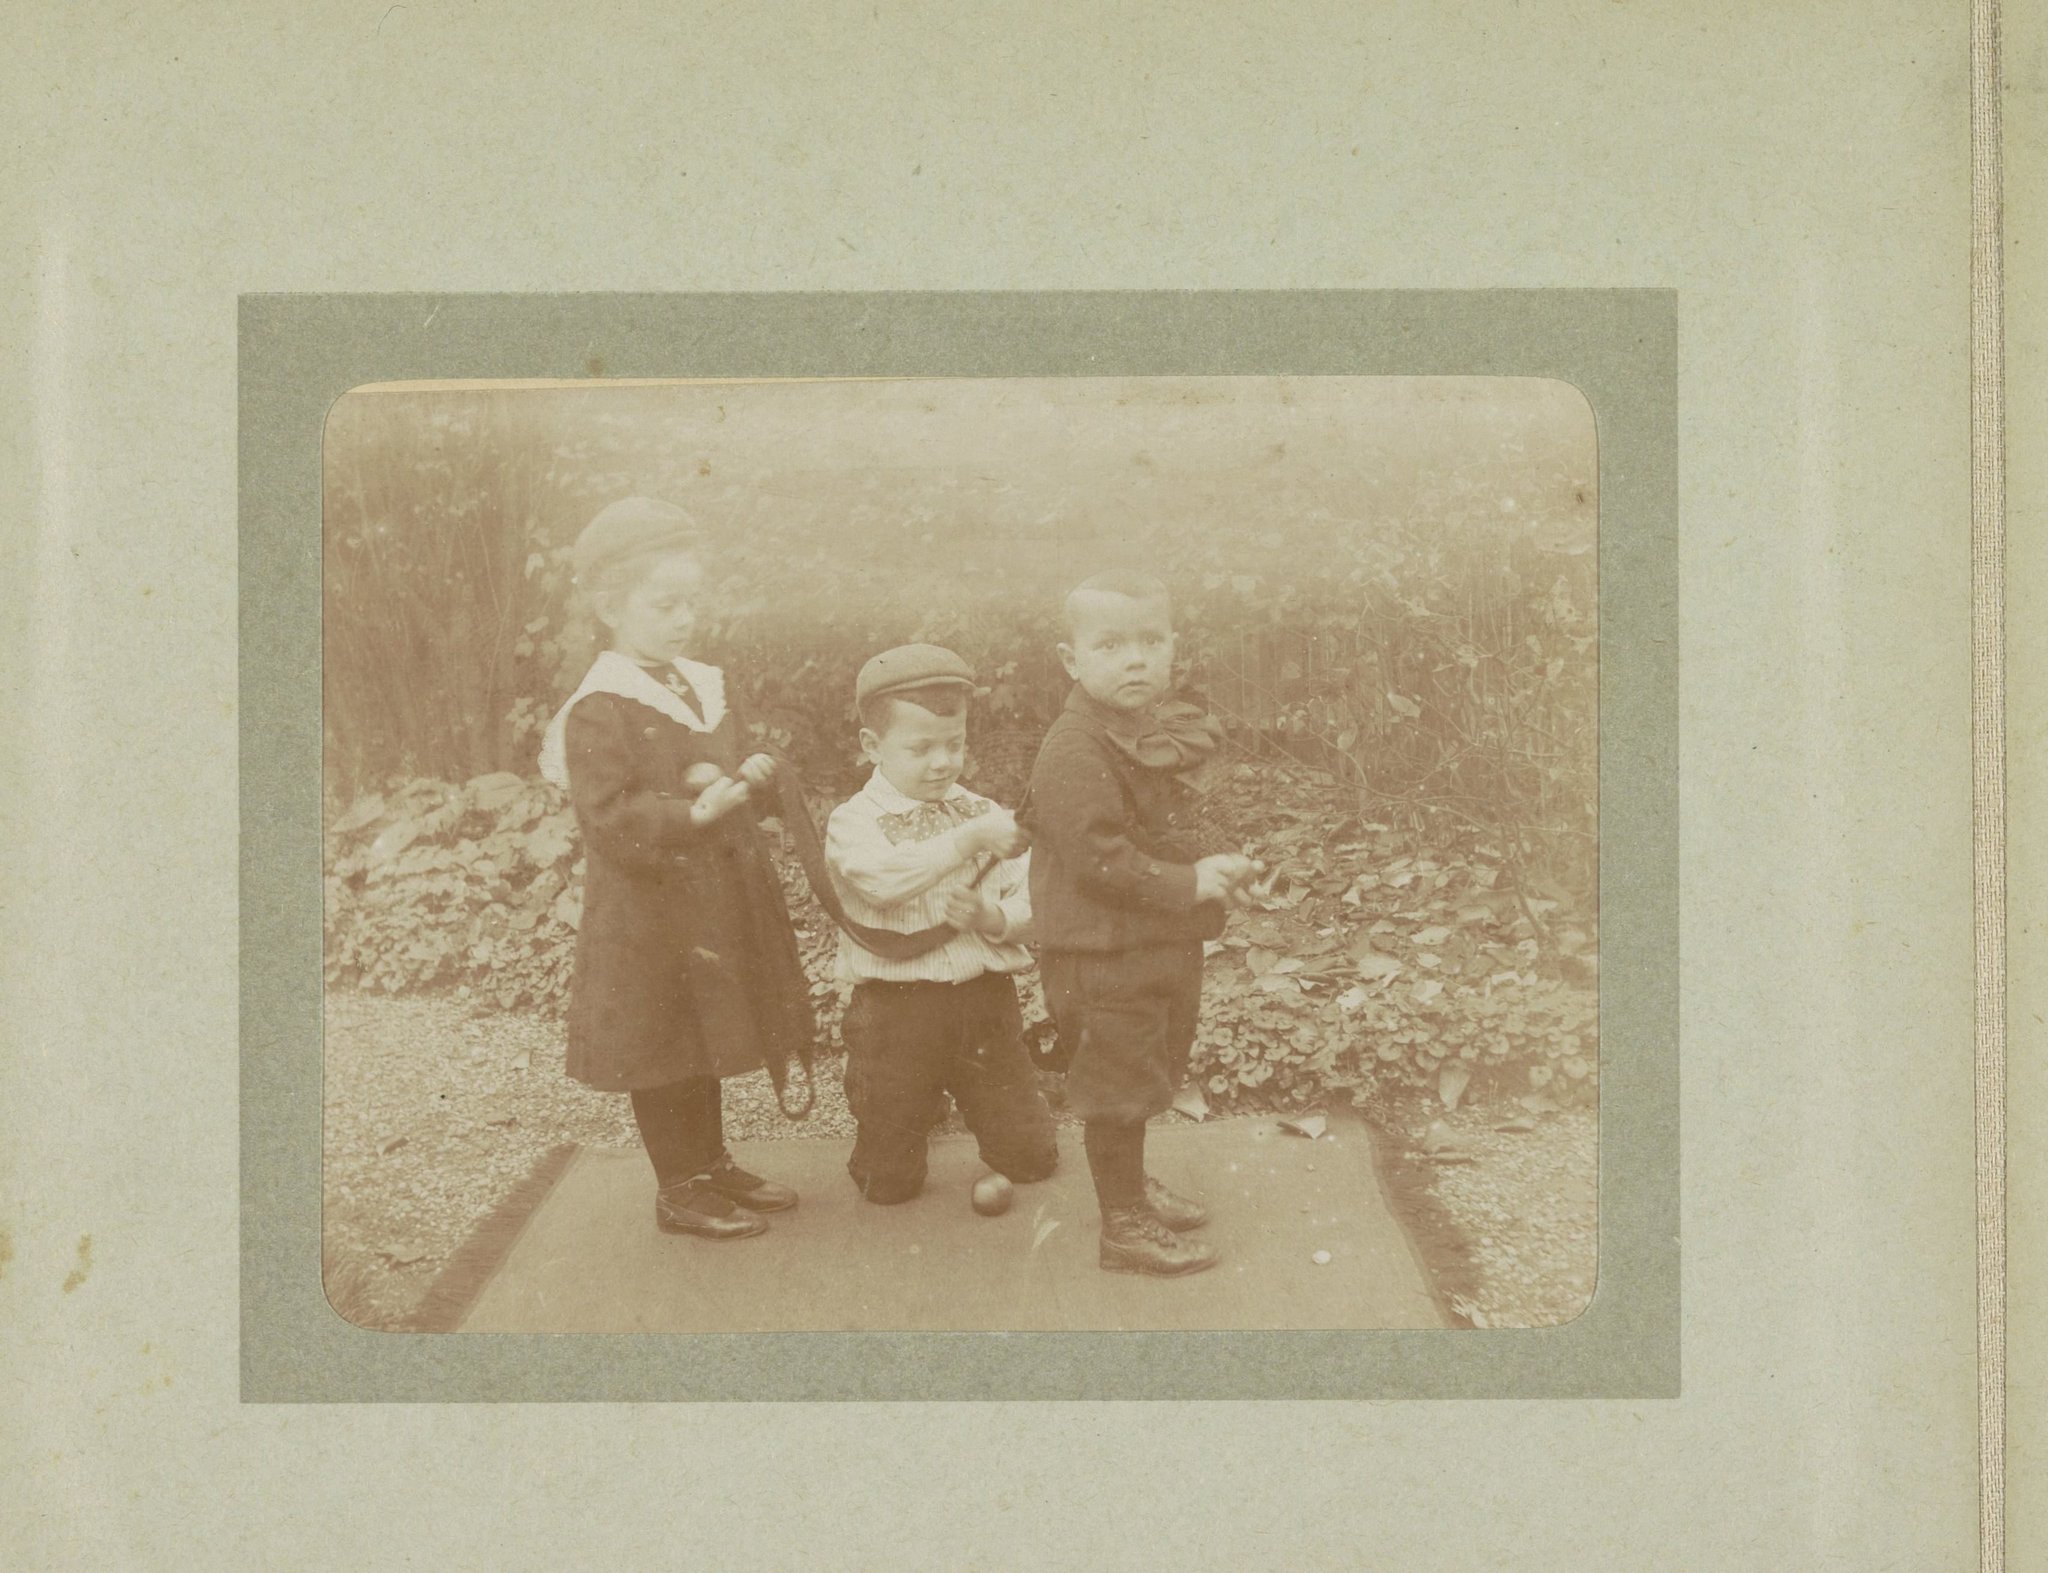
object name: photograph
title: Drie kleuters in een tuin spelend met een lint, waarschijnlijk de tweeling Ad (midden) en Johanna (links) en Han (rechts) van der Kop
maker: willem carel van der kop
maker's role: amateurfotograaf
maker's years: 1869-1924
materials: cardboard, paper, photographic support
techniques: daylight paper print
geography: schoonhoven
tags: twins, family life, head-gear: cap, tot, toddler ~ the ages of man, brothers or sisters (second degree family relationships)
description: Onderdeel van Fotoalbum met opnames van Ad, Johanna en Han van der Kop, hun moeder W.G. Hoogendijk en familieleden.